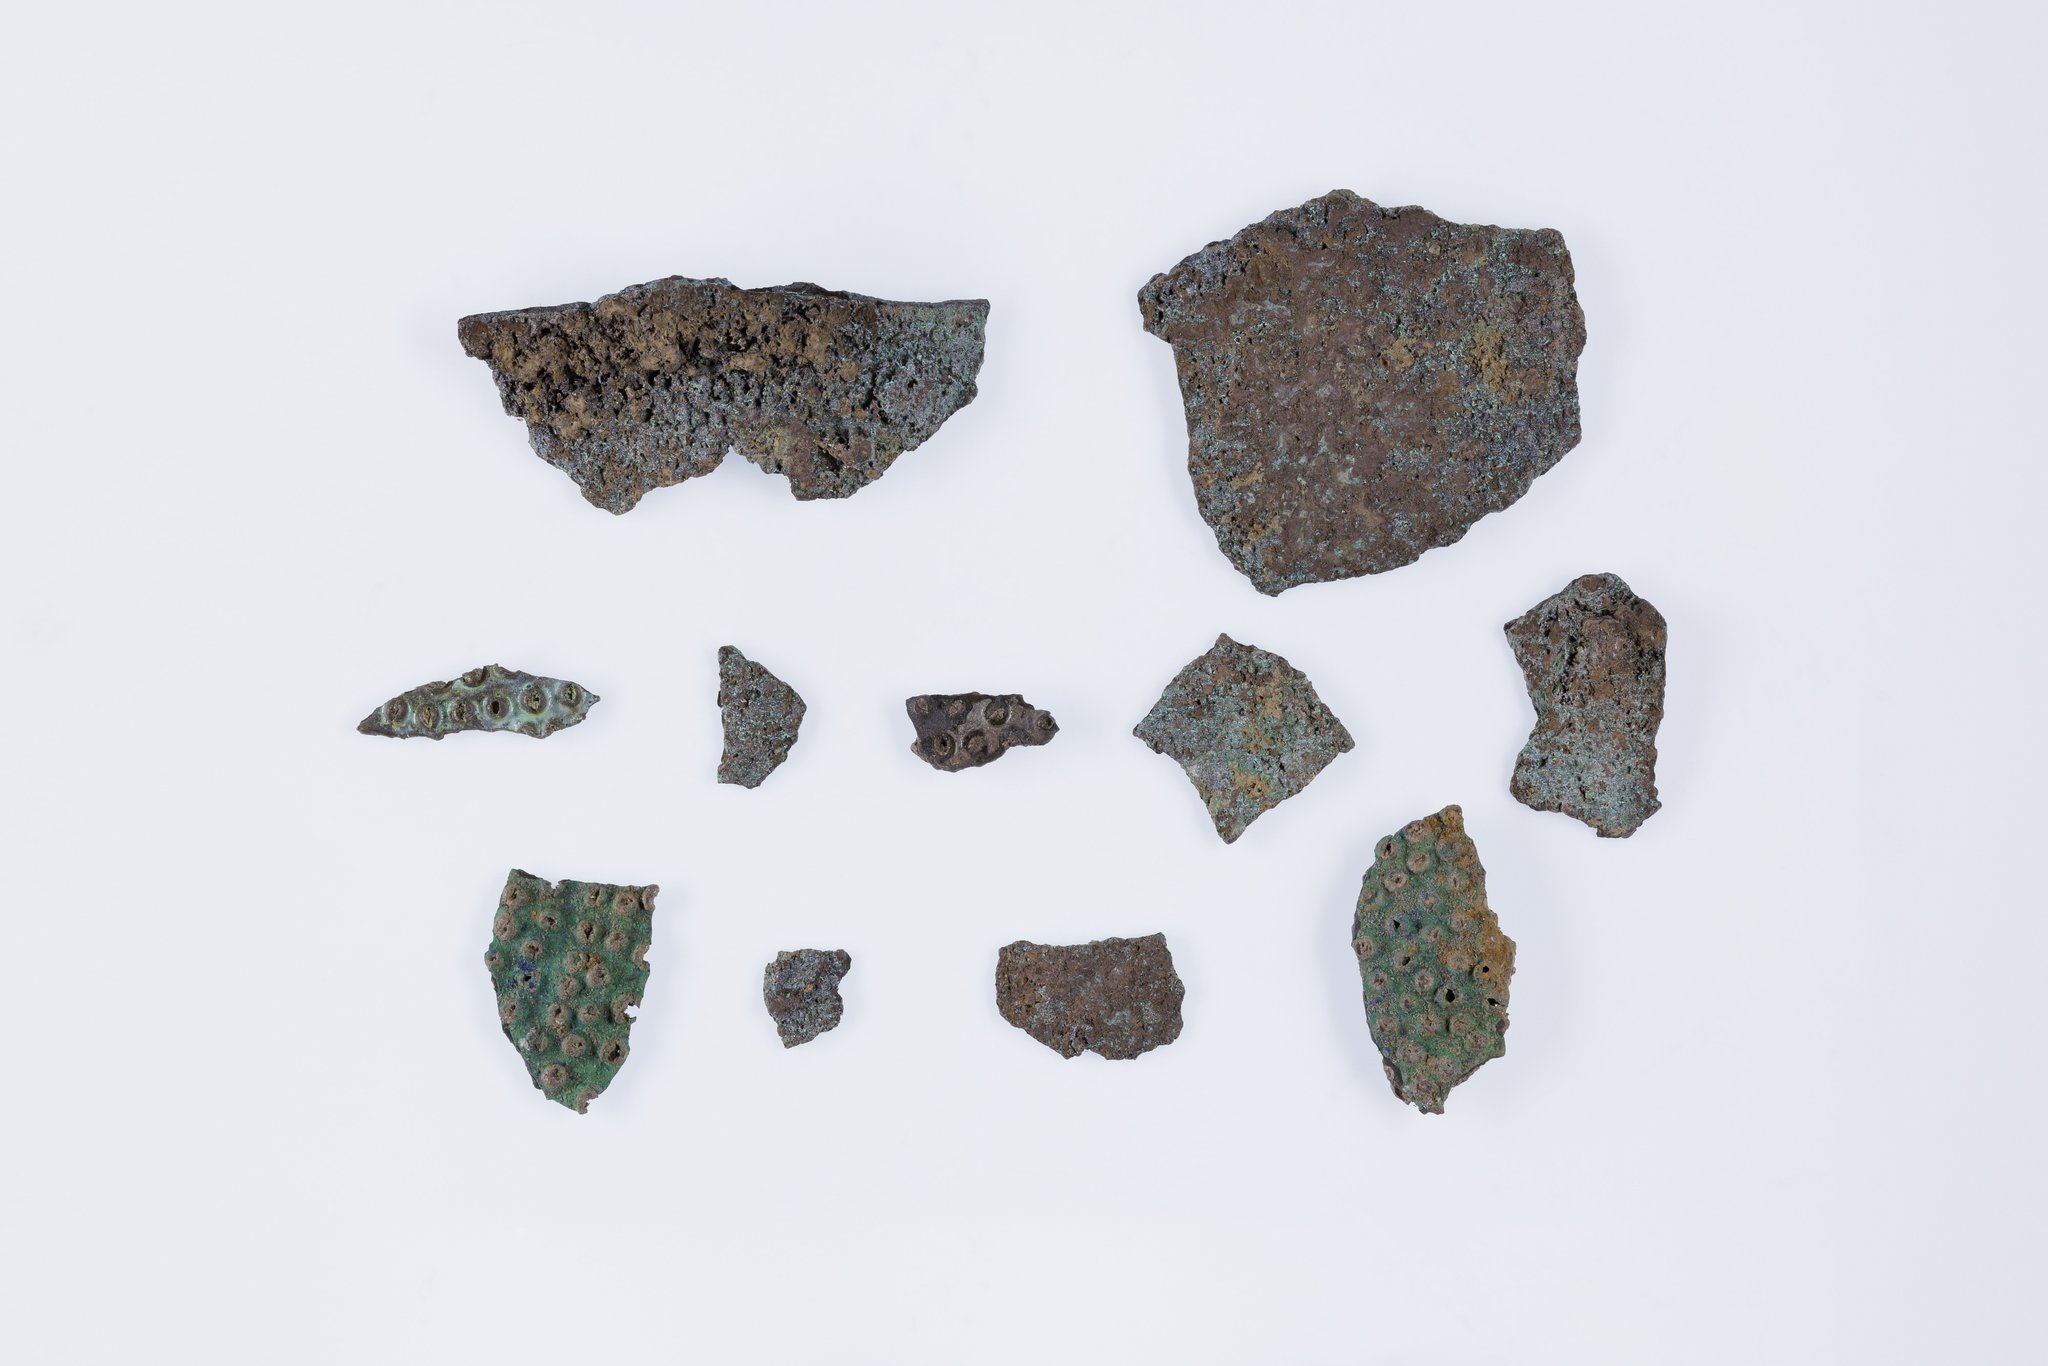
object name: vessel fragment, tell basta treasure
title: Strainer fragments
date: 1070-712 BCE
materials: silver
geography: egypt